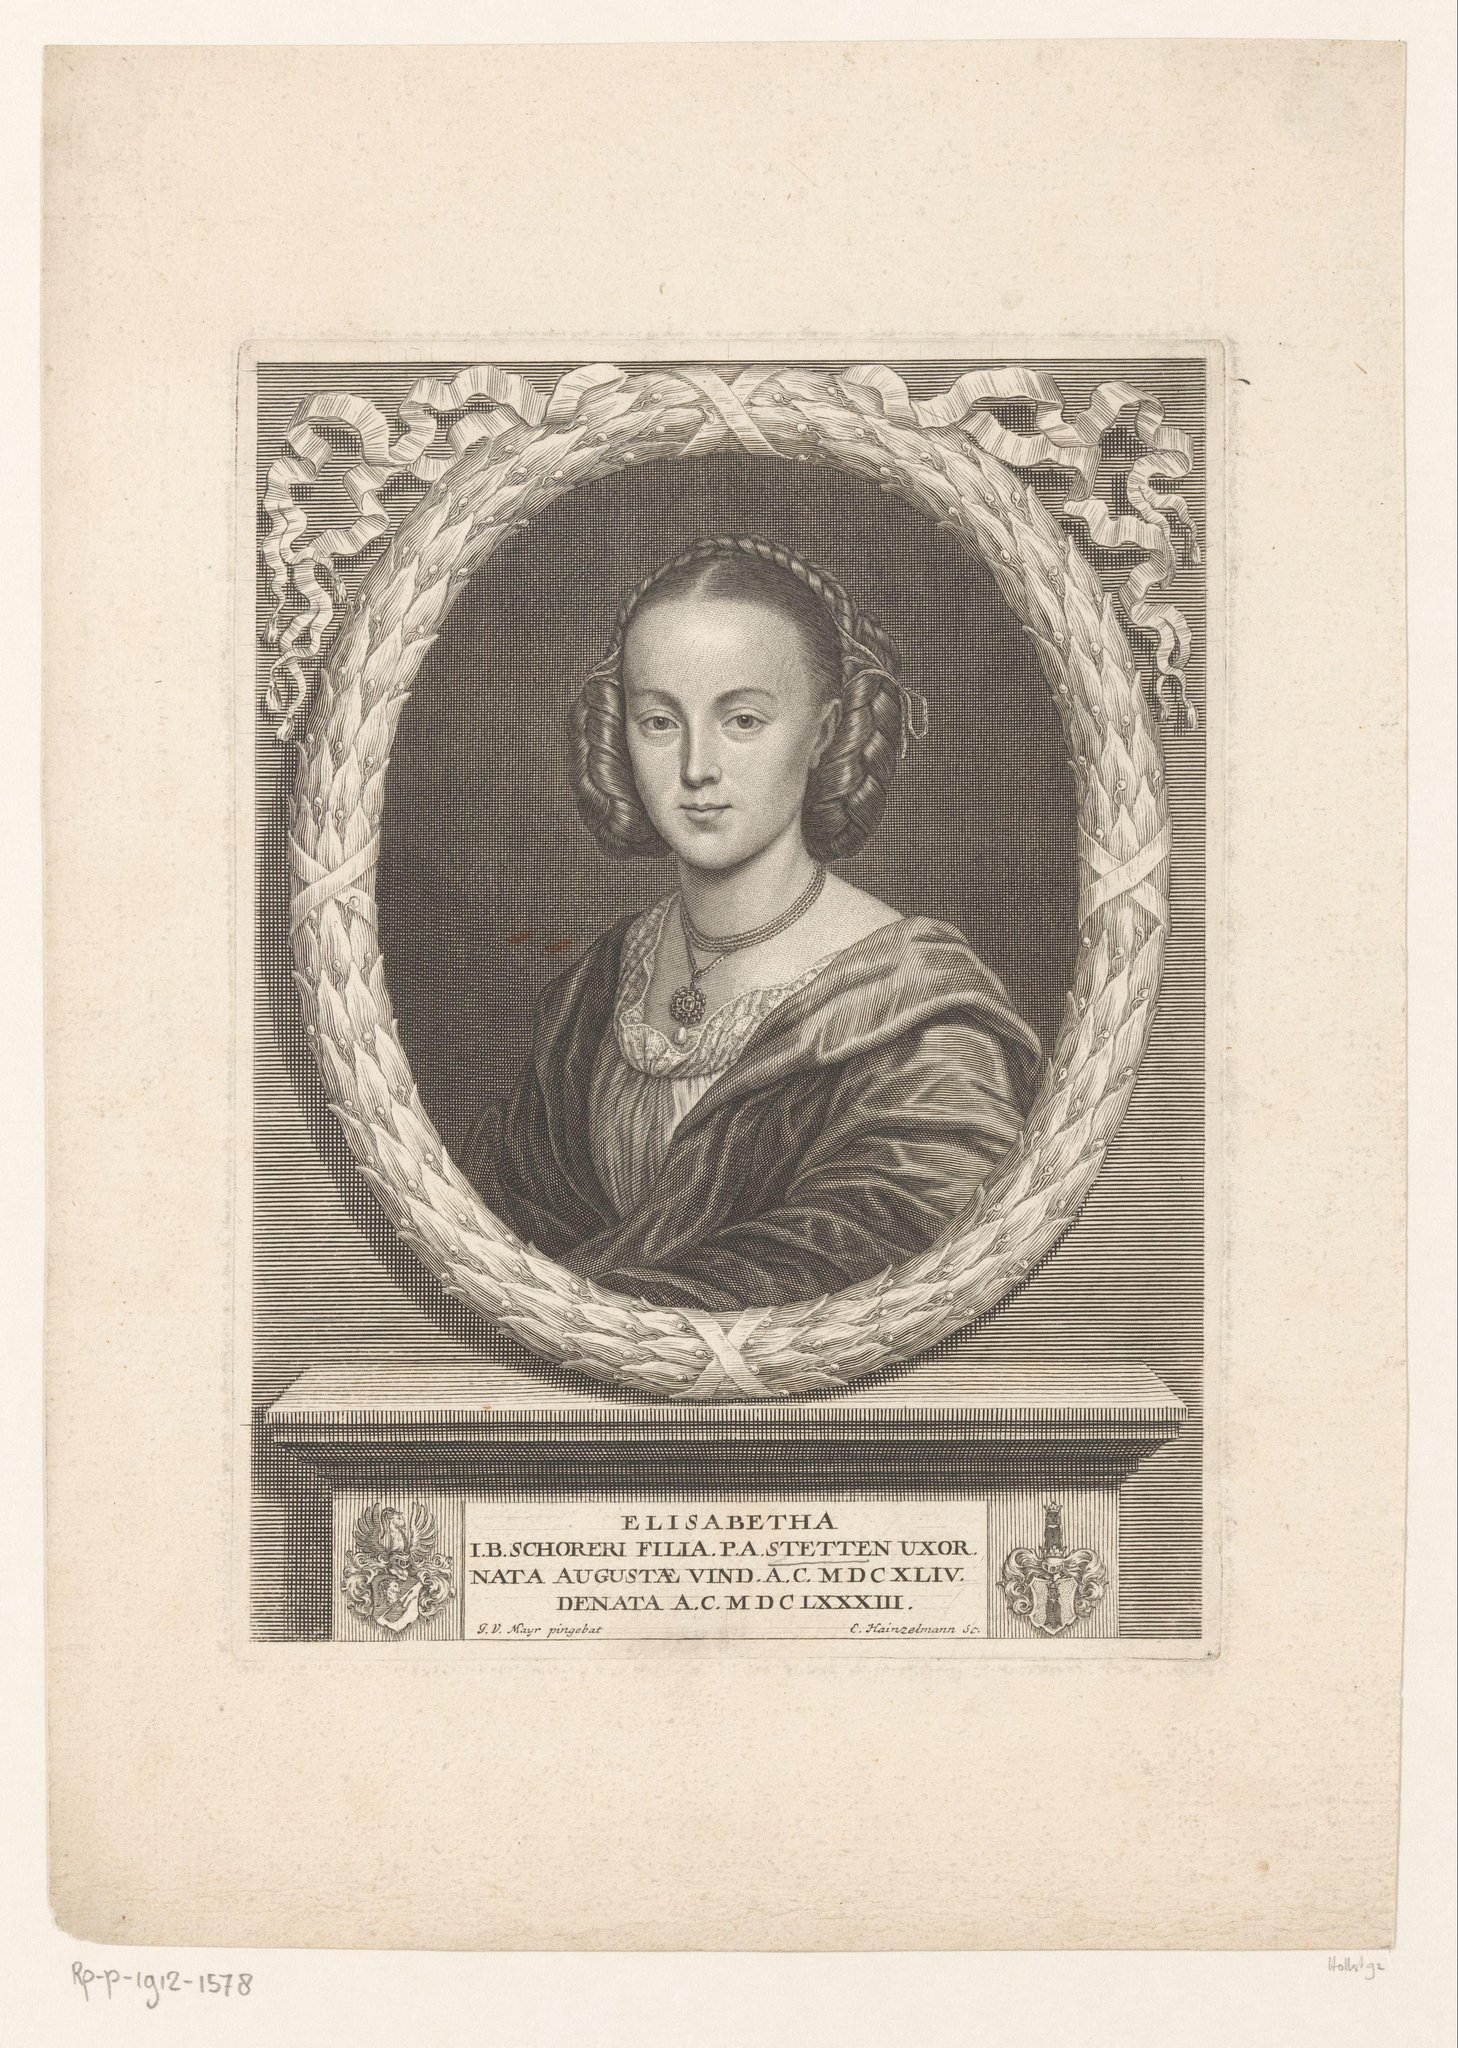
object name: print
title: Portret van Elisabeth von Stetten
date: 1683-1693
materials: paper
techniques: engraving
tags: historical persons - bb - woman, pendant, trinket, 'breloque', ornament ~ festoon, garland, armorial bearing, heraldry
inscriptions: collector's mark: Lugt 2228